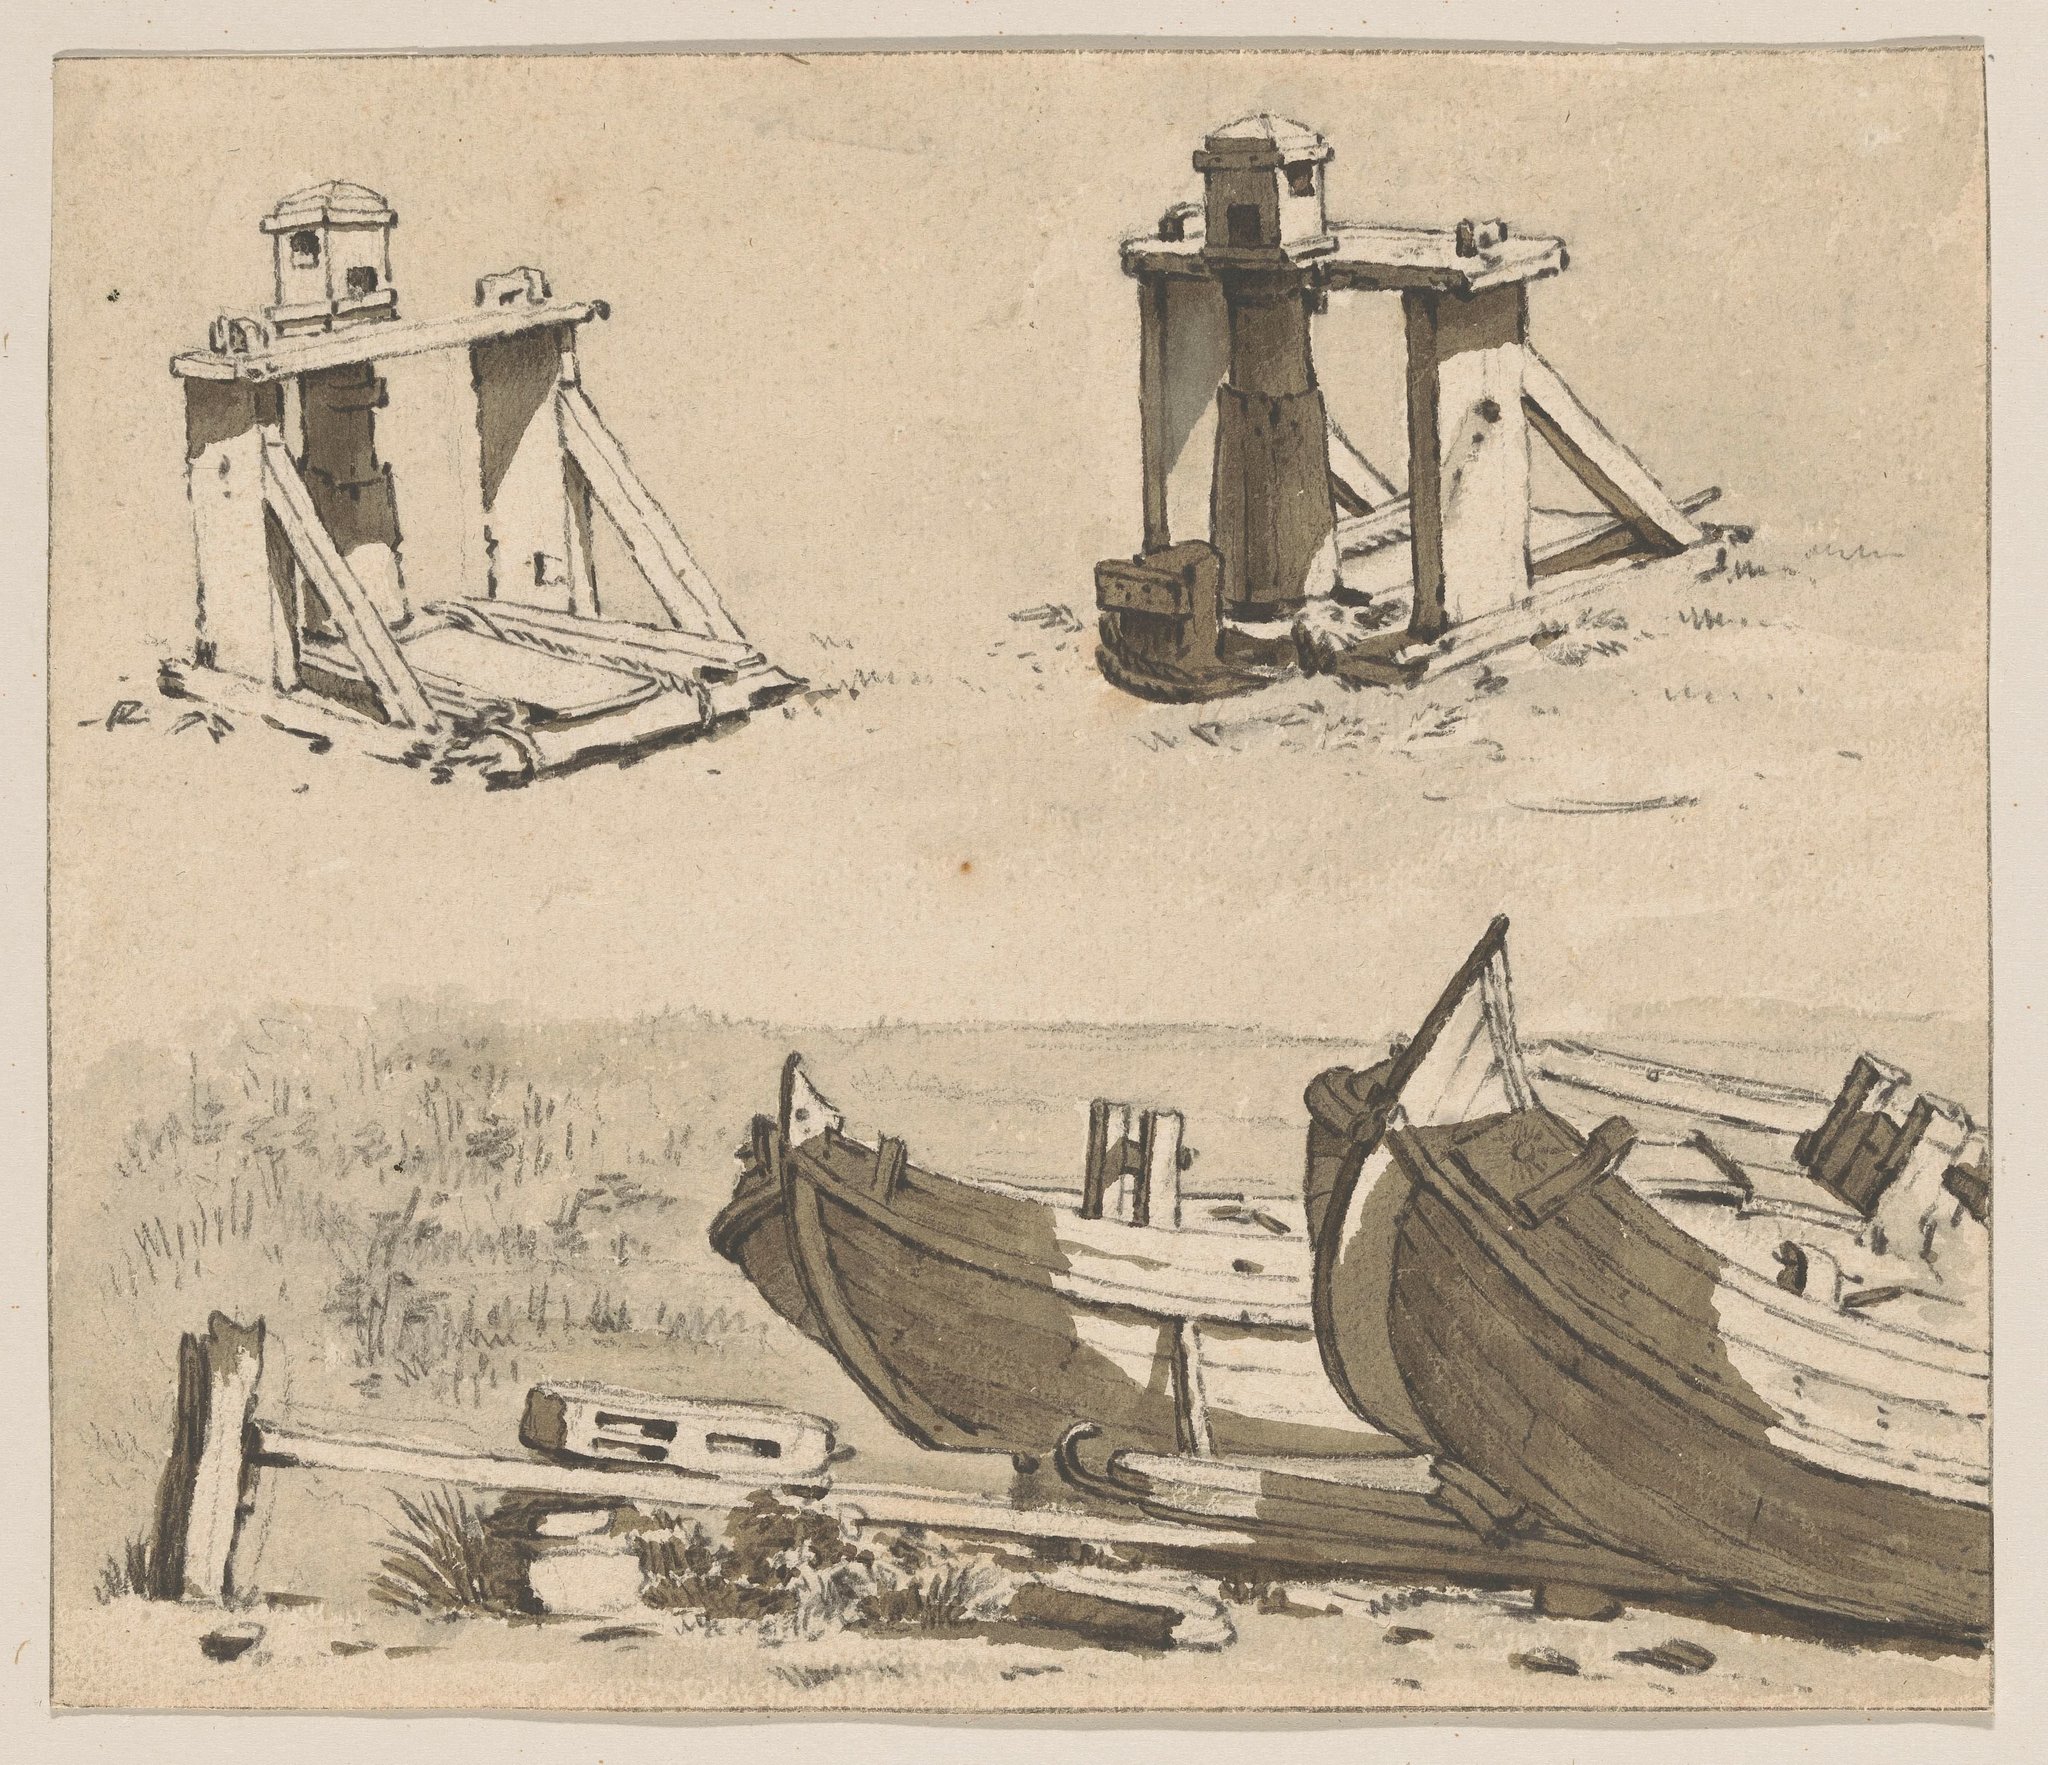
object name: drawing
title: Twee boten voor reparatie aan de kant en een windas van twee richtingen gezien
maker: george pieter westenberg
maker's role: draughtsman, painter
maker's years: 1791-1873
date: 1801-1873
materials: chalk, paper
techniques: brush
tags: tools, aids, implements ~ crafts and industries: windlass, ships (in general)